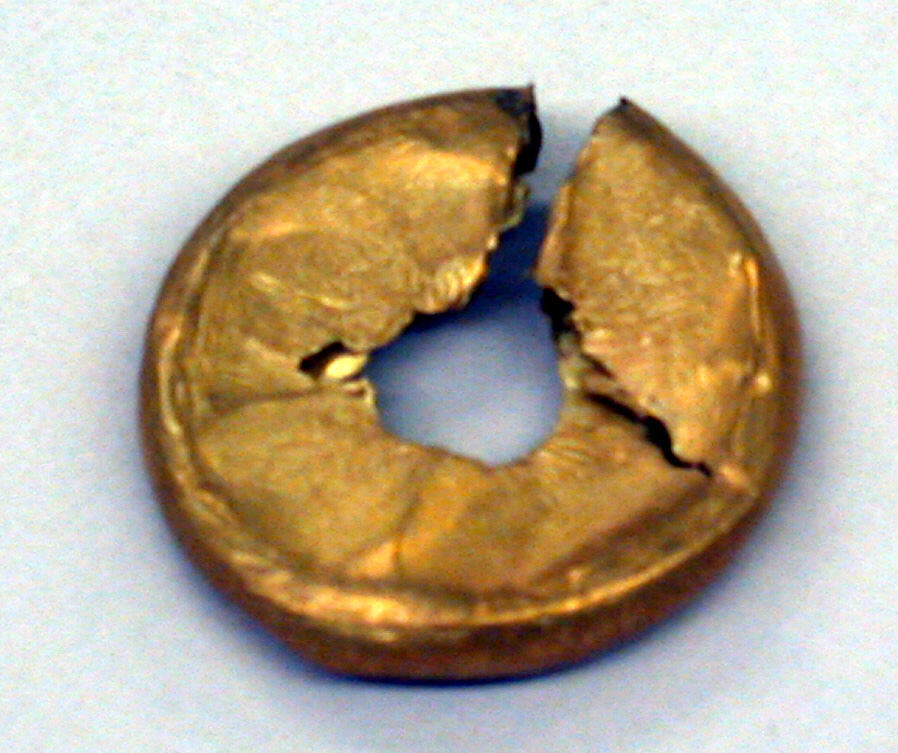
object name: ear ornament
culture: visayes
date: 1301-1500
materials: gold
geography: philippines